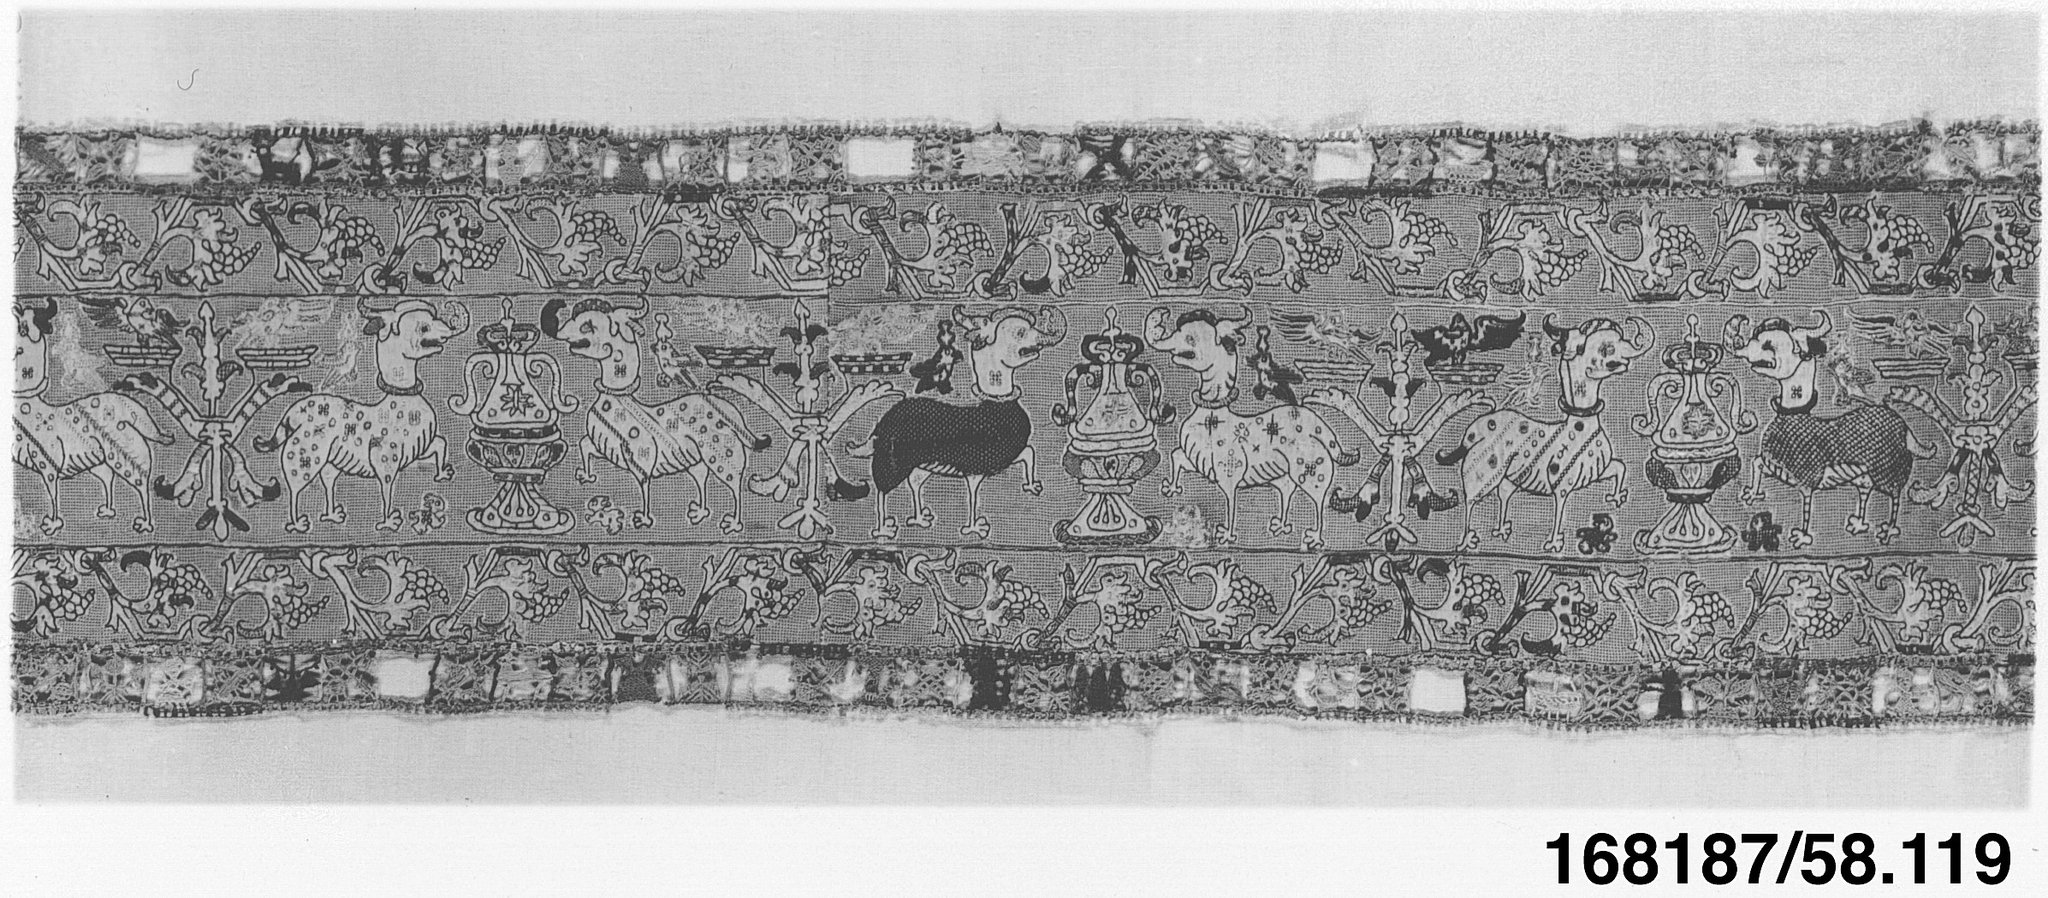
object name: panel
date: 1501-1600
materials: linen, silk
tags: birds,mythical creatures